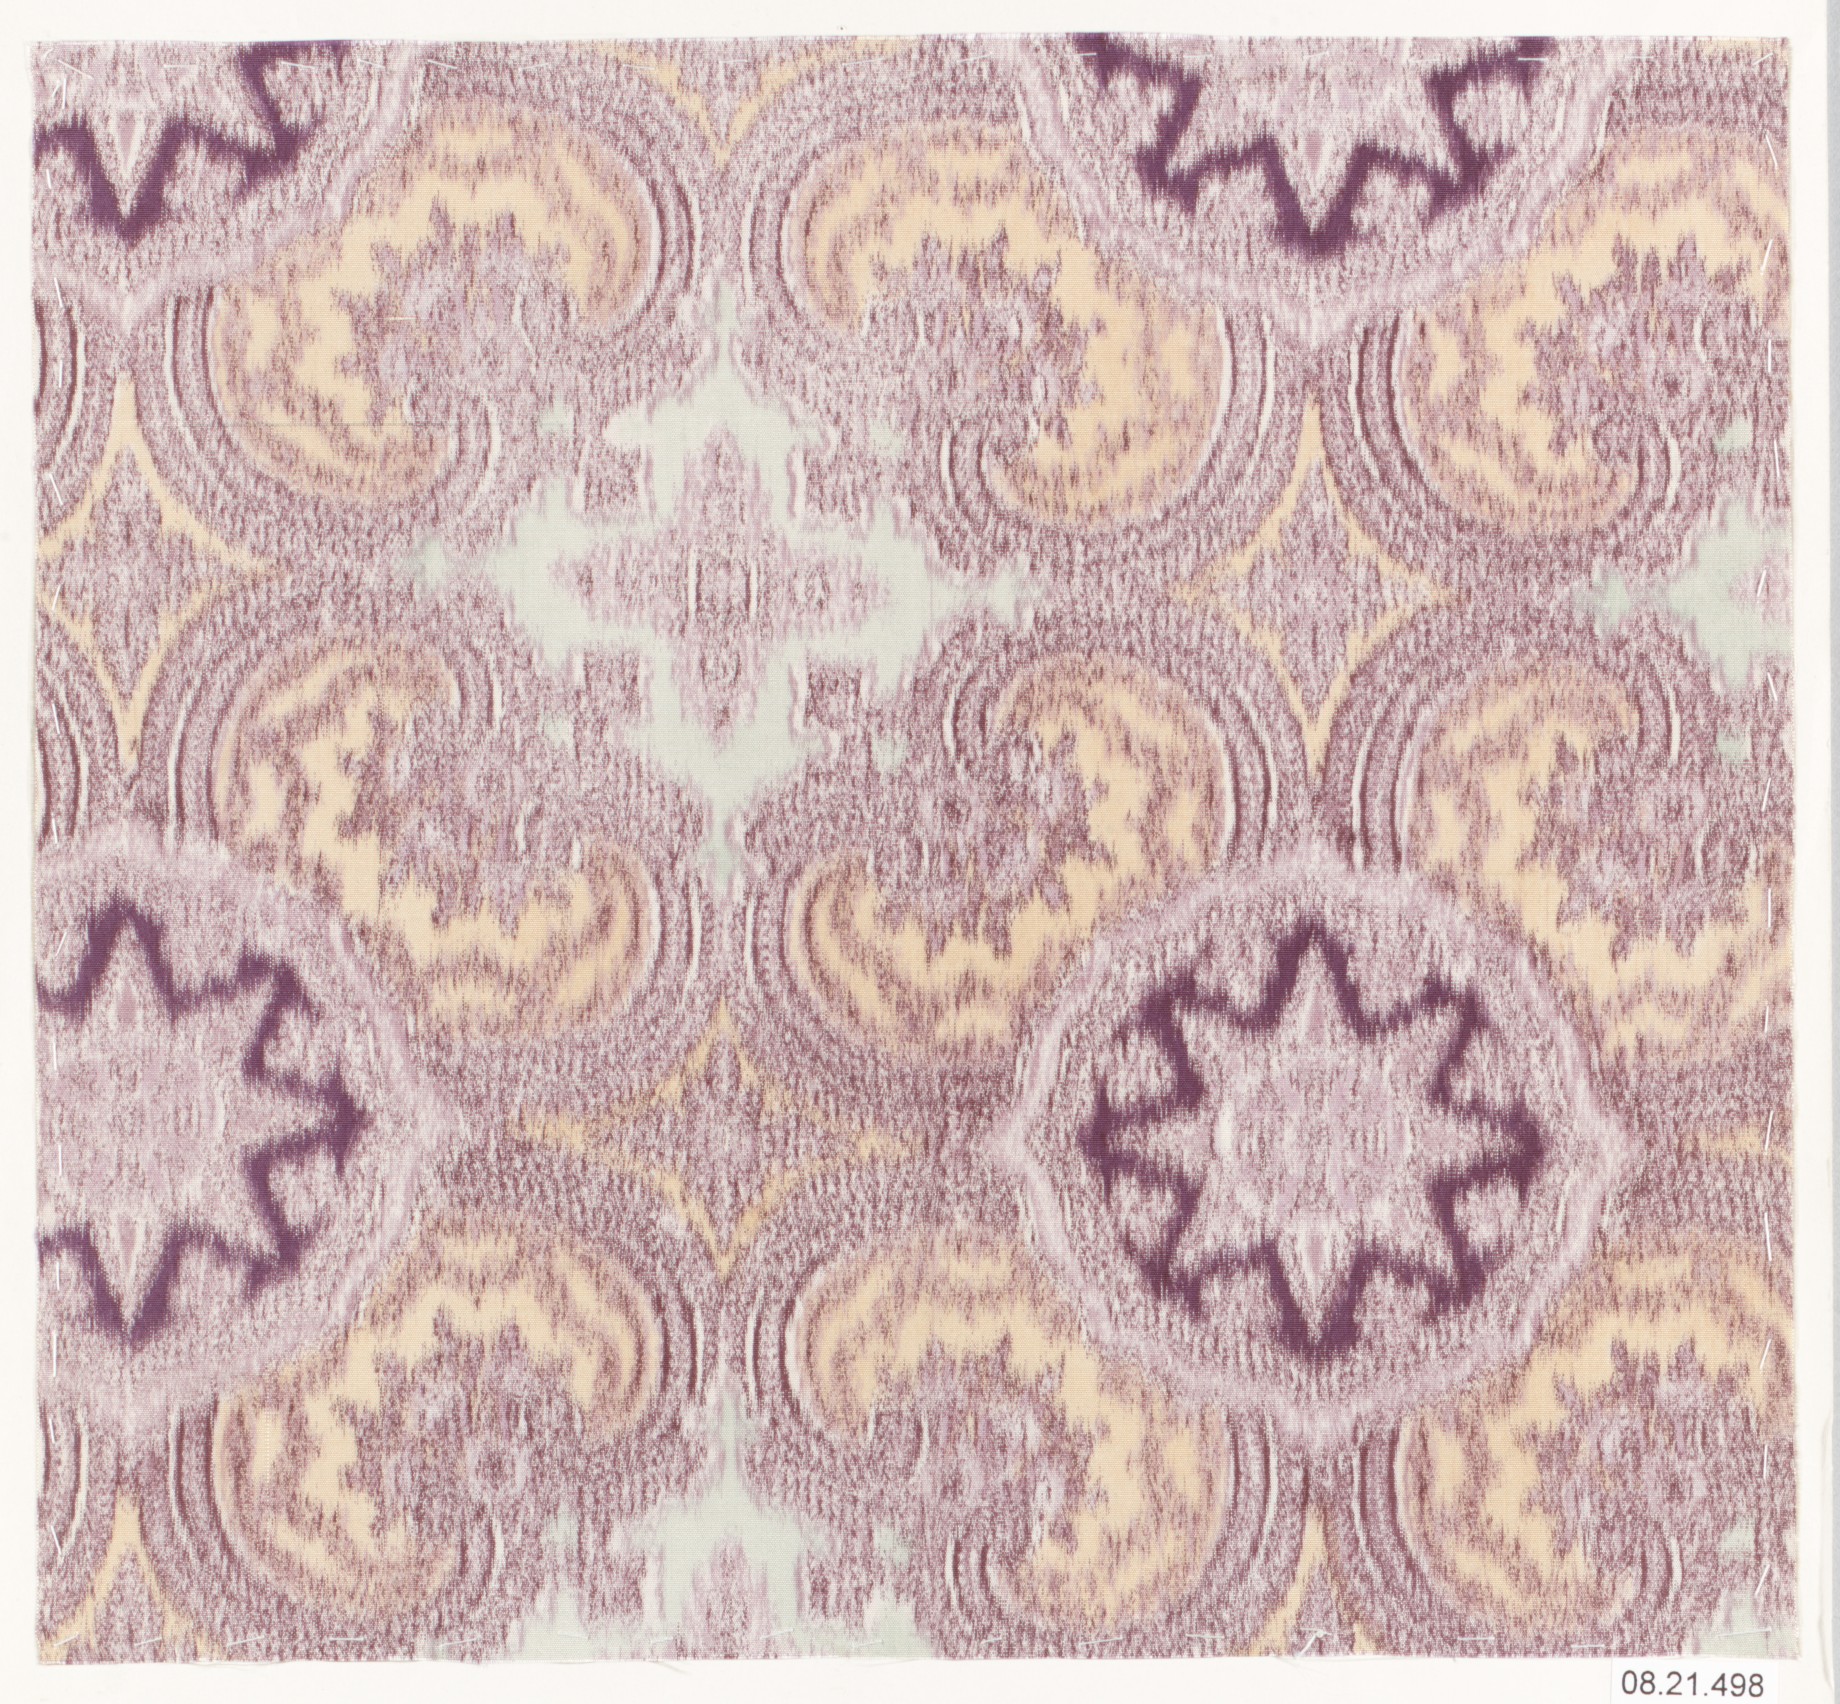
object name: textile sample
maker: Anonymous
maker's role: designer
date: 1900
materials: silk